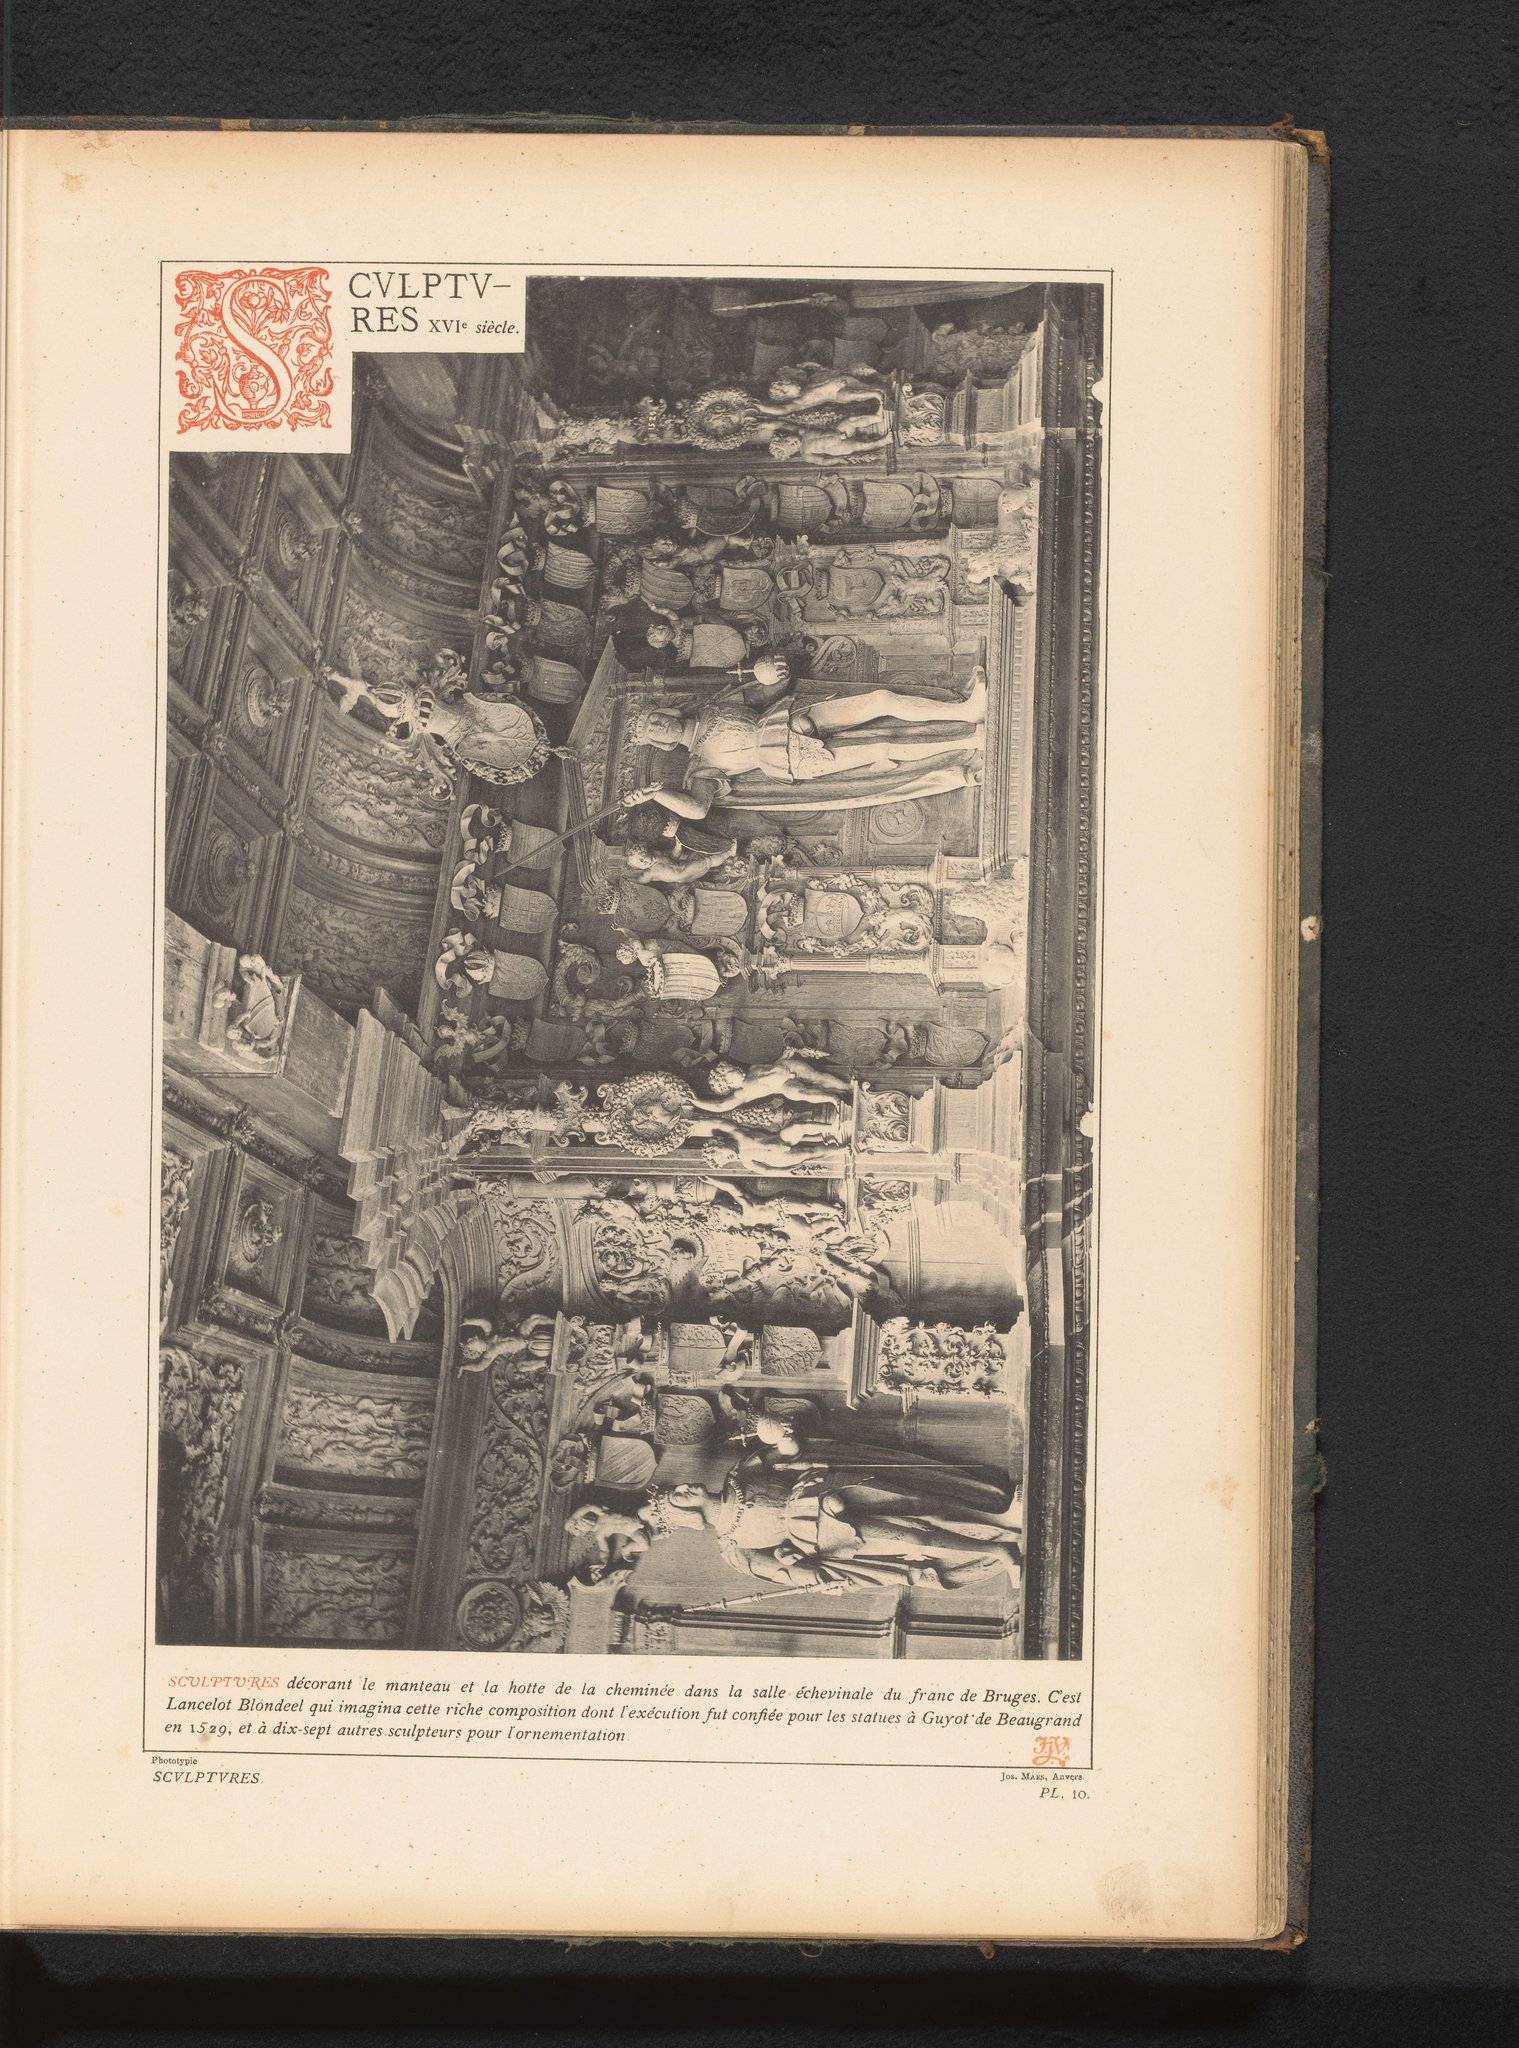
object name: photomechanical print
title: Sculptures, XVIe siècle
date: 1882-1887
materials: paper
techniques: photograph, photolithography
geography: antwerp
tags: townhall, piece of sculpture, reproduction of a piece of sculpture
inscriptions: monogram: ‘JJvY’, inscription: ‘SCULPTURES décorant le (...)’, inscription: ‘SCULPTURES. - PL. 10.’